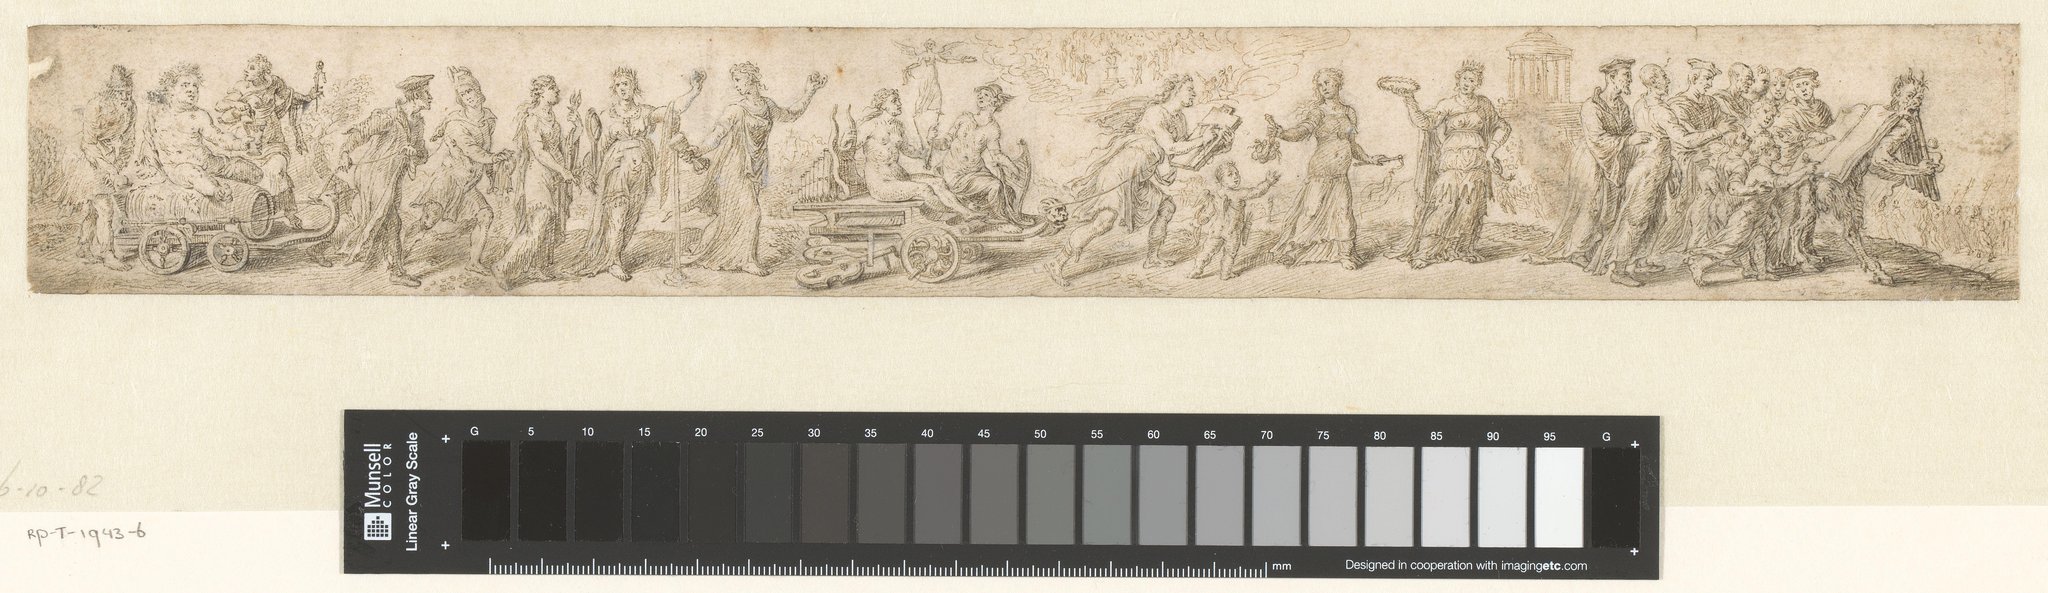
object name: drawing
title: Laus Deo in Alinario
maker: matthys van den bergh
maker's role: draughtsman, print maker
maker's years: 1617-1687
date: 1656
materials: ink, paper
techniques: pen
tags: triumph of silenus, bacchanal: bacchus with his wine-flushed train (thiasos)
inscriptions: date: ‘1656’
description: Een optocht van allegorische vrouwengestalten trekt naar een ronde tempel op een berg op de achtergrond. De optocht van vrouwengestalten wordt afgewisseld door twee zegekarren, waarop Mercurius met een harp, een naakte vrouw met een klein orgel en een jeugdige Silenus op een wijnvat zijn gezeten. De optocht wordt voorafgegaan door een panfluit spelende sater, op wiens rug een opengeslagen boek rust, waaruit een stoet van geleerden en knapen zingt.